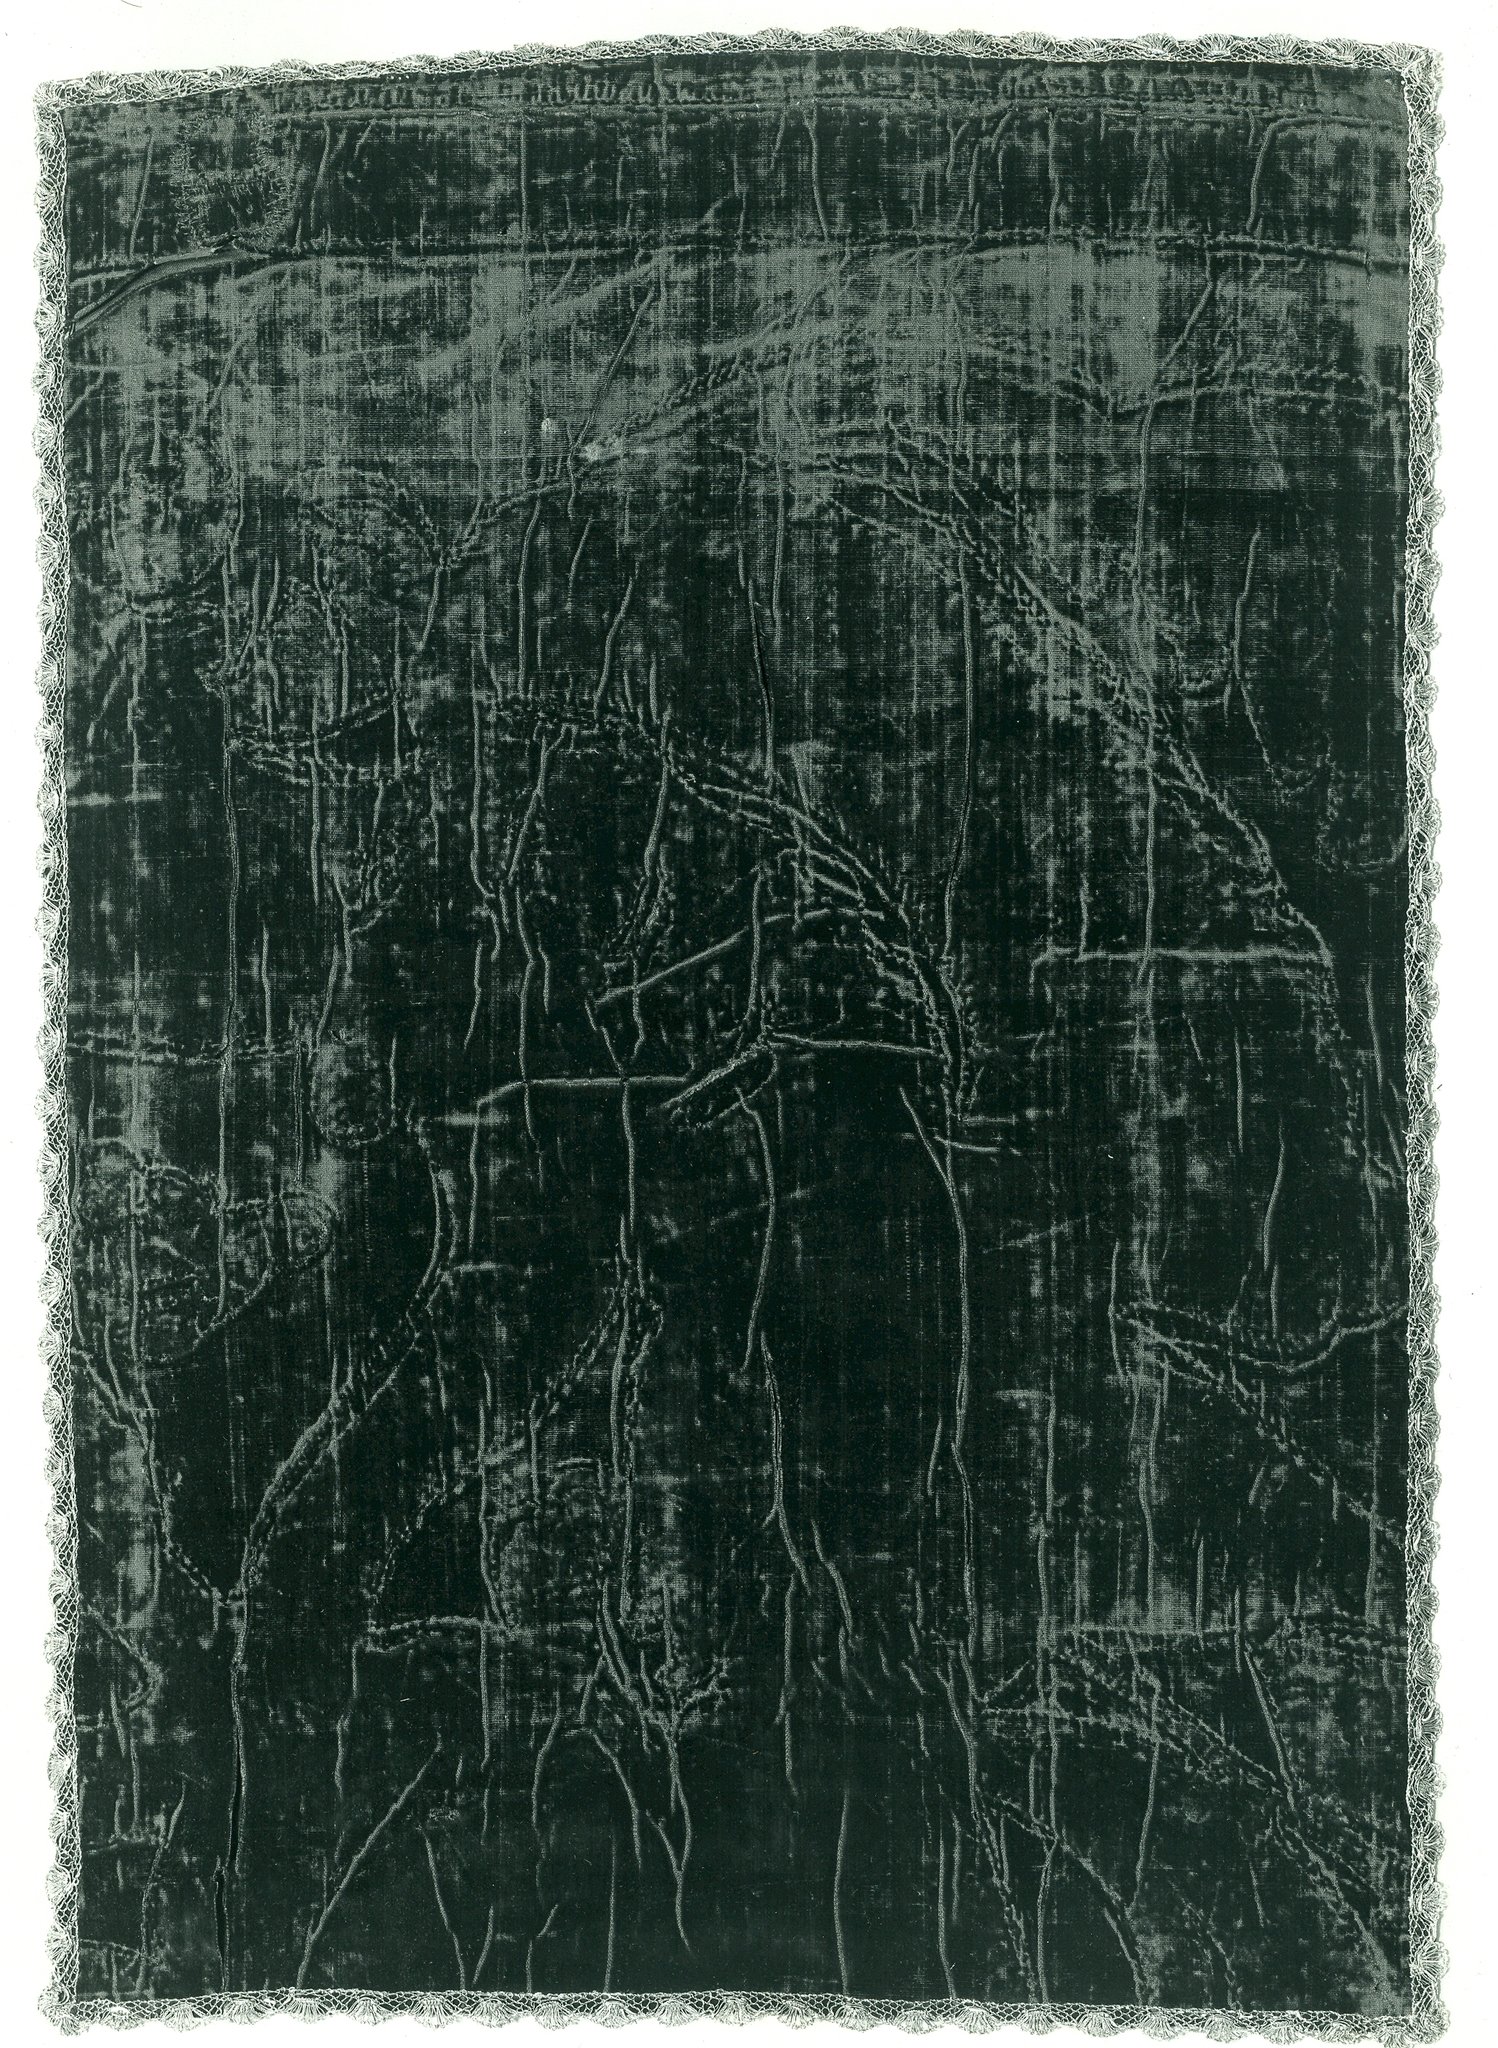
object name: textile cover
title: Cover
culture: italian or spanish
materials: cotton, metal, silk